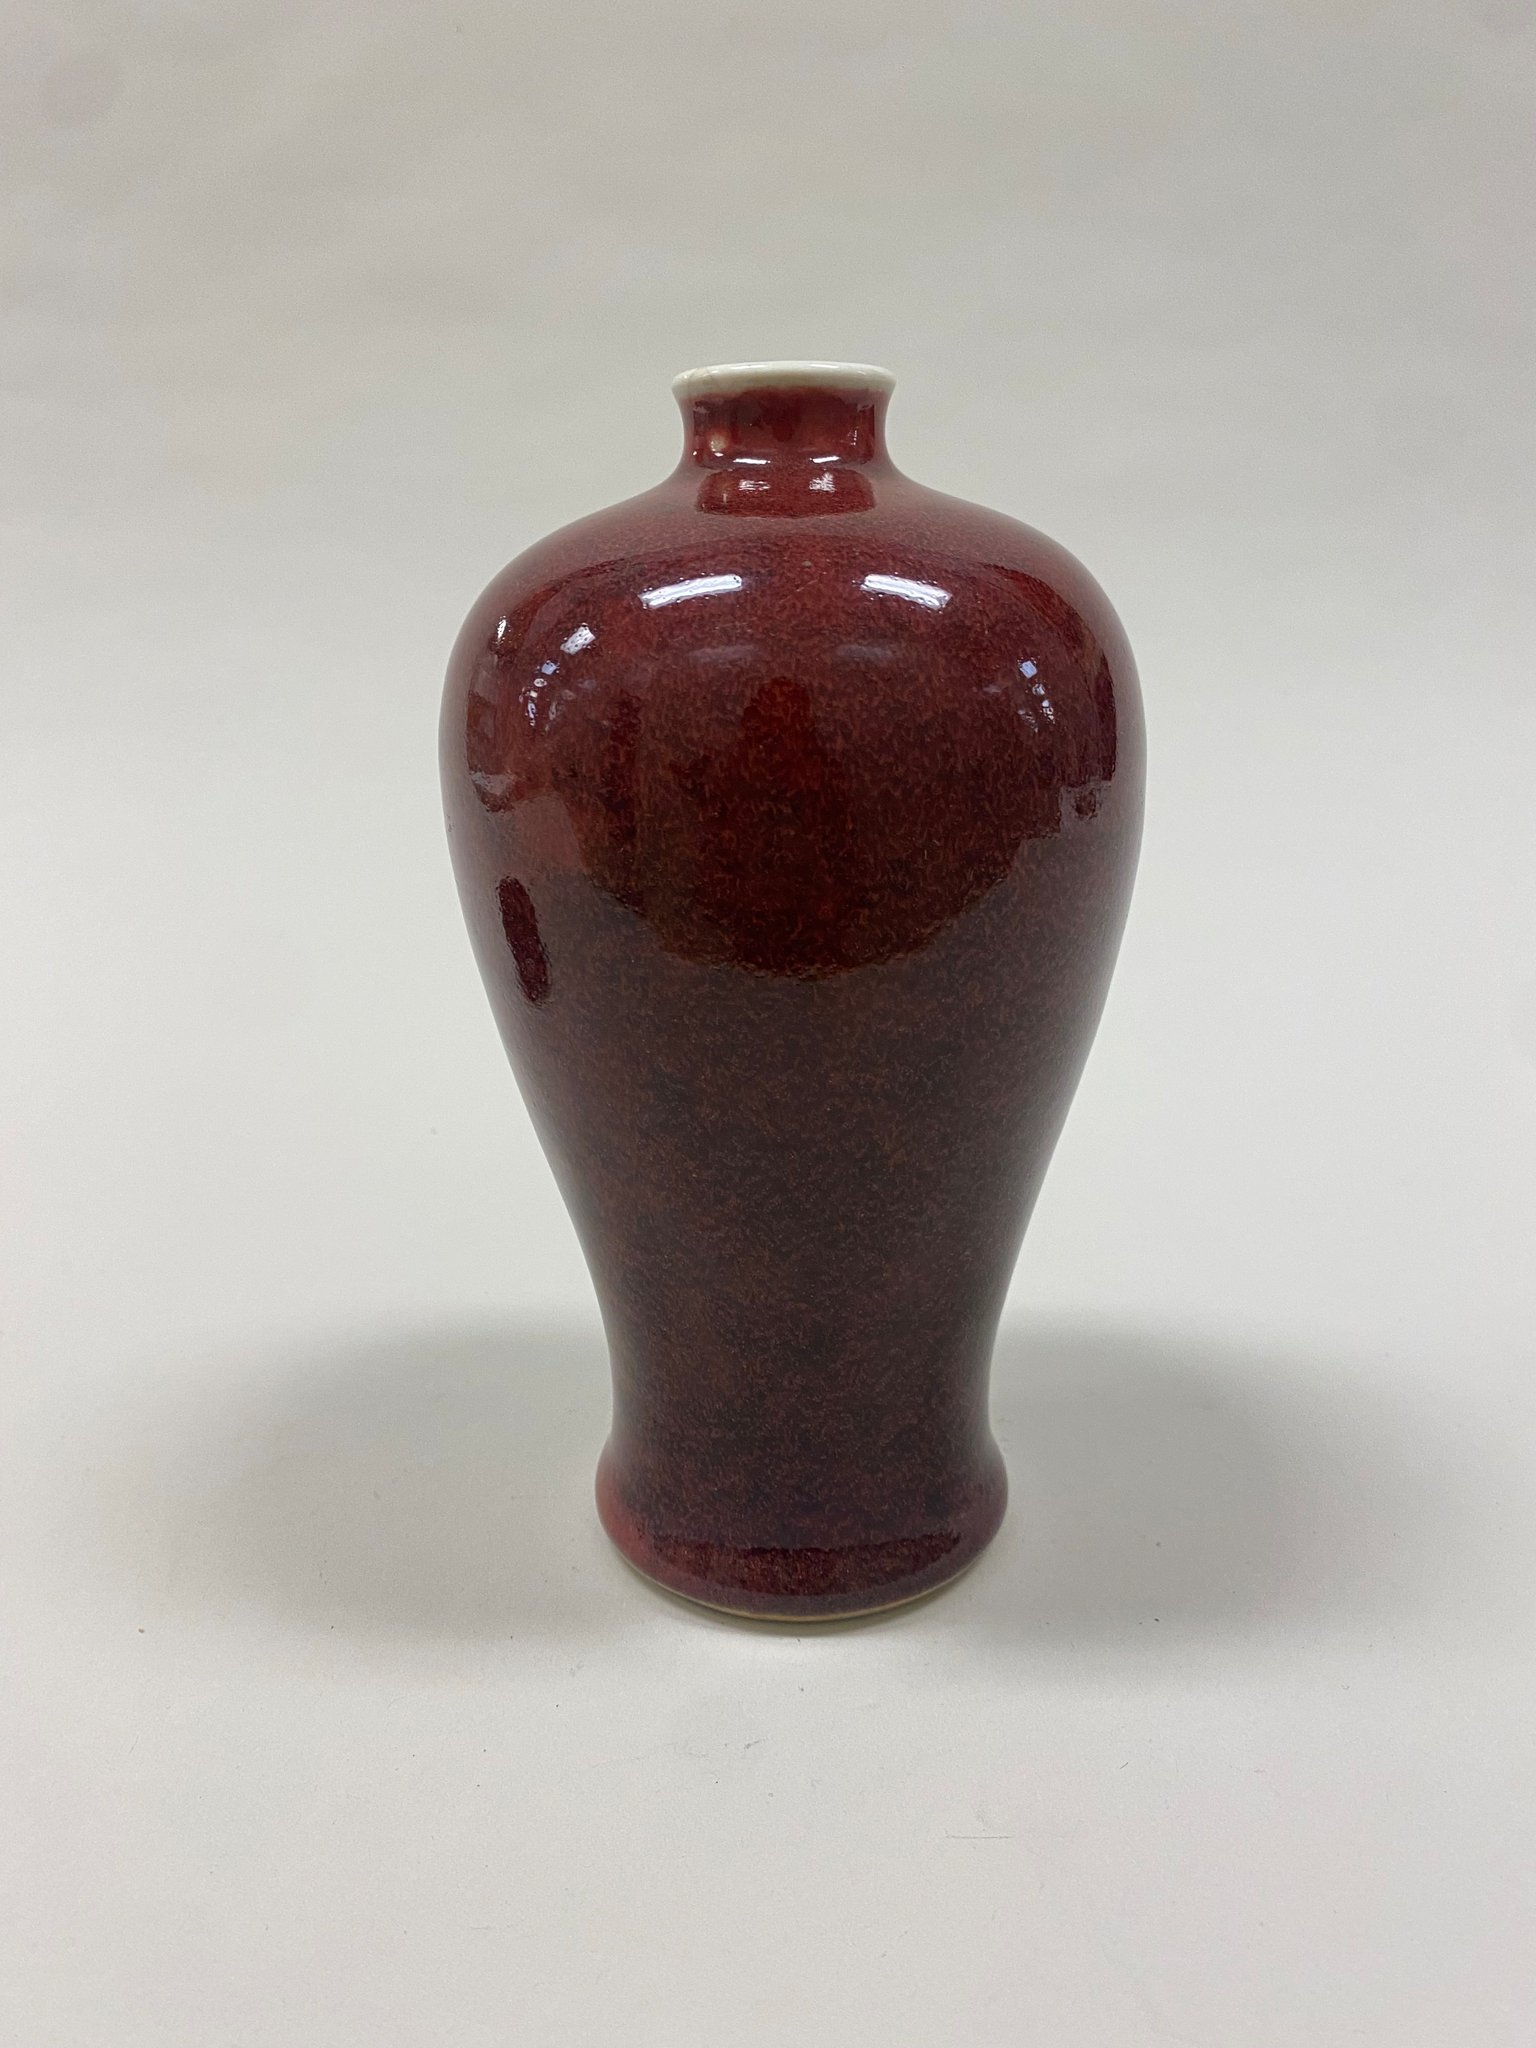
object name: vase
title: Meiping vase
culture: chinese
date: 1667-1733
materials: copper, glaze, porcelain